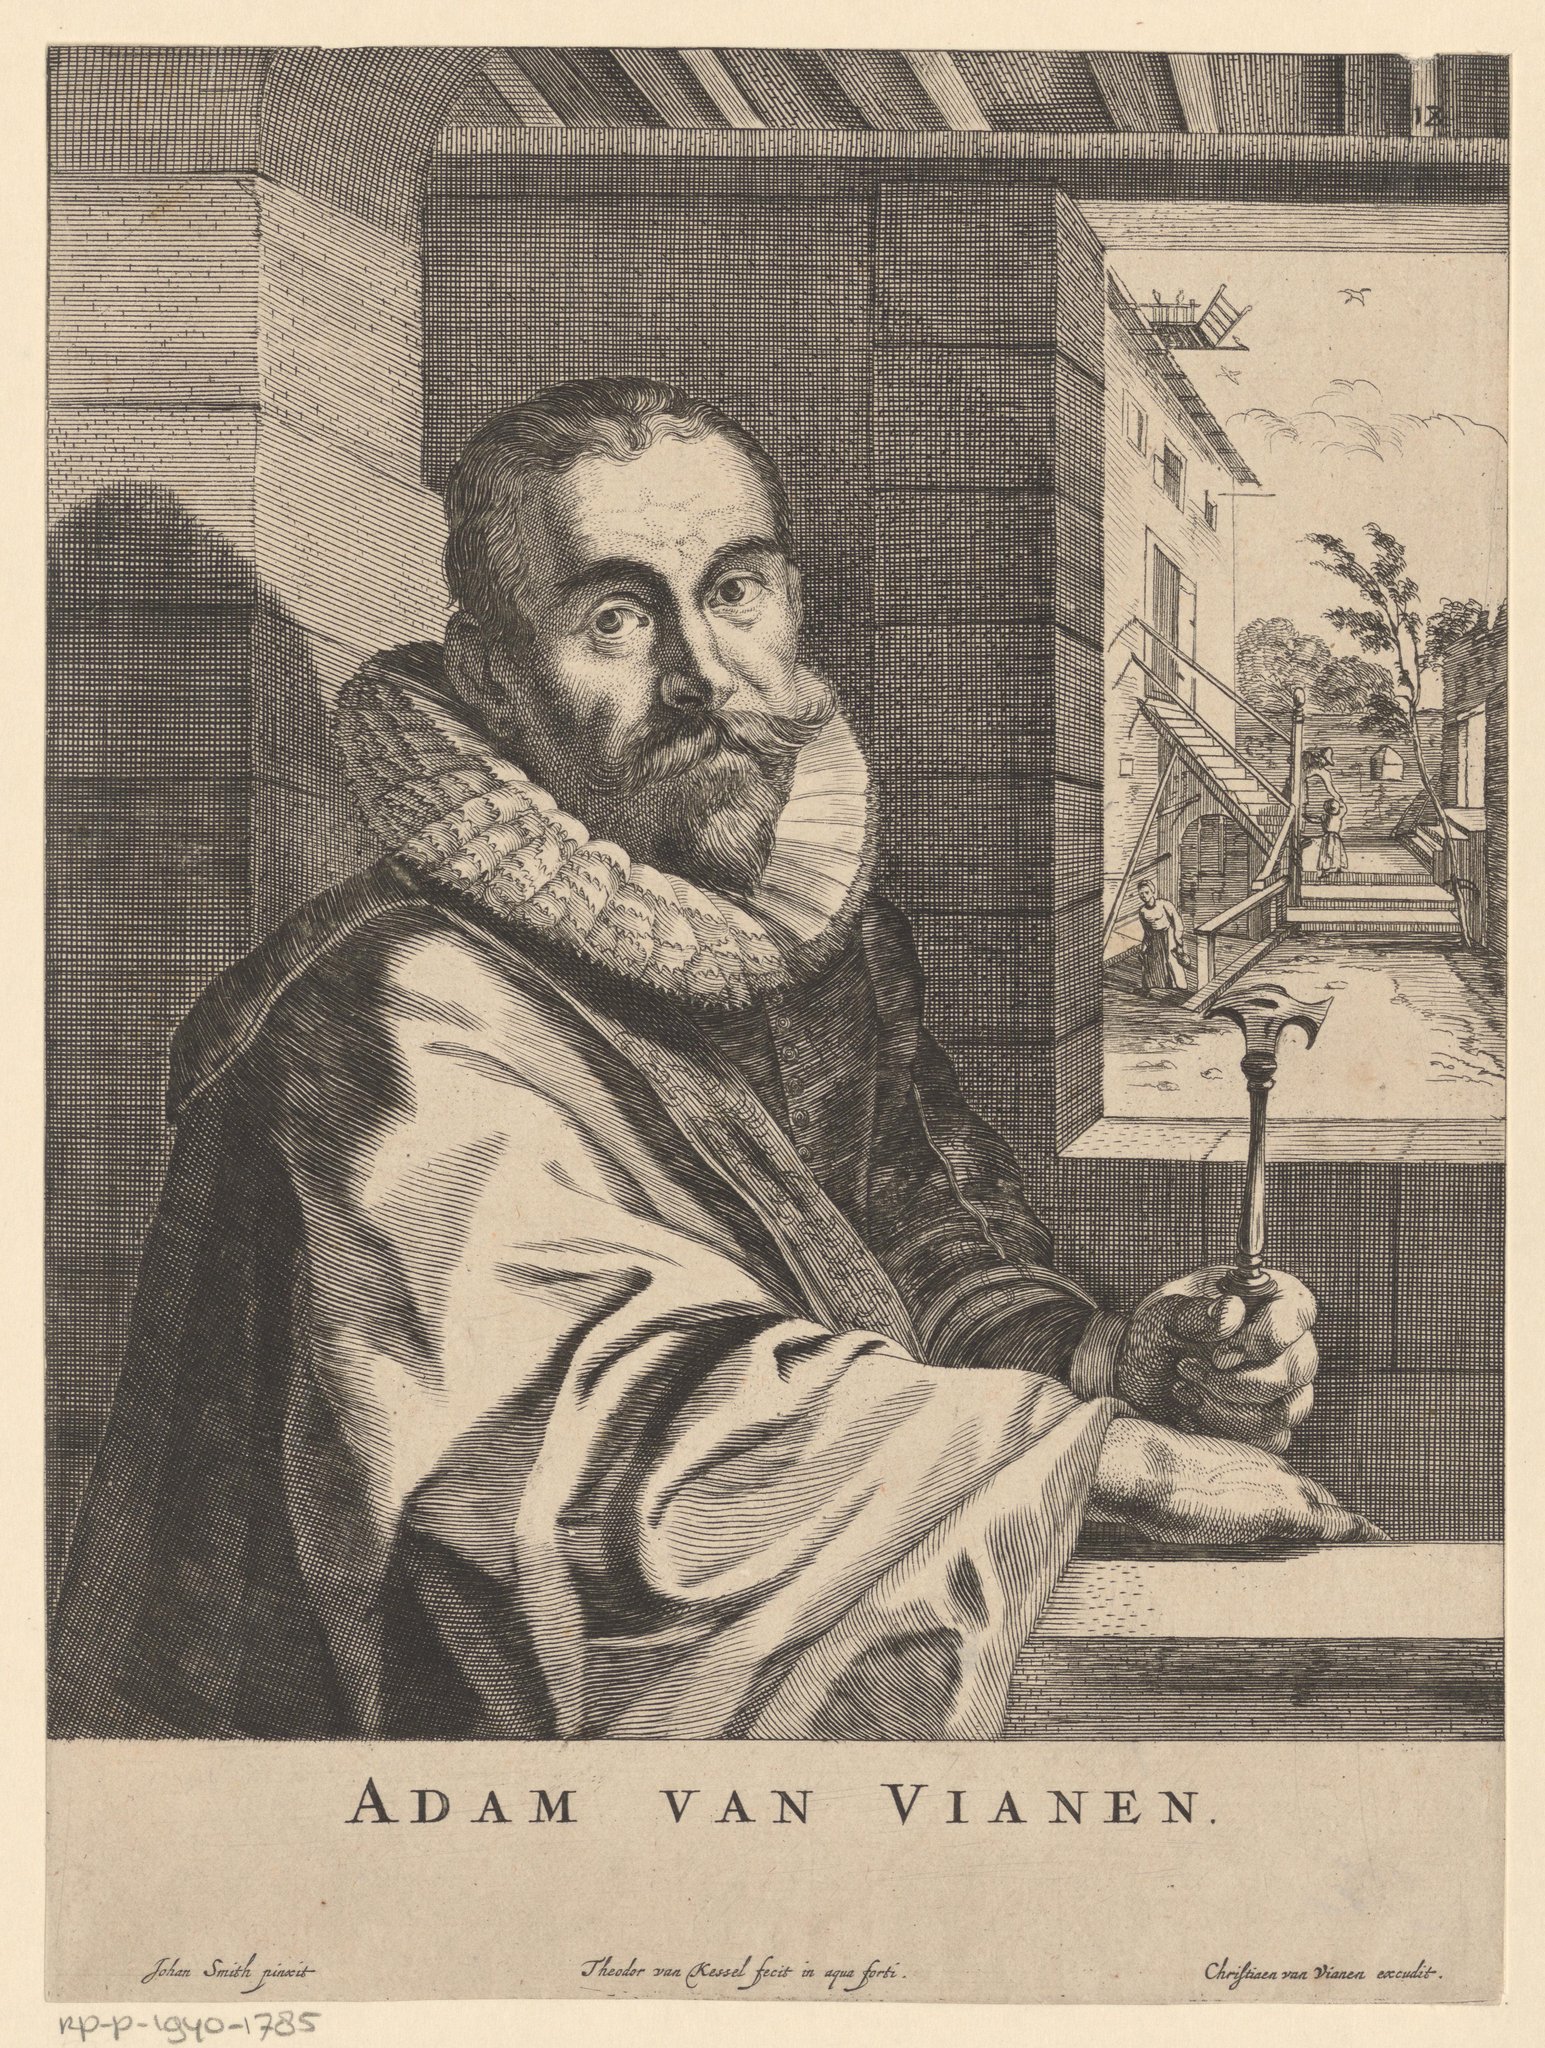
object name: print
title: Portret van Adam van Vianen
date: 1630-1660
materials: paper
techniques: engraving, etching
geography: northern netherlands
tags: utrecht, print maker, draughtsman, silversmith, adam van vianen (i), historical persons, tools, aids, implements ~ crafts and industries: hammer, portrait, self-portrait of craftsman in applied arts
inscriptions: collector's mark: Lugt 2228, collector's mark: Lugt 2760